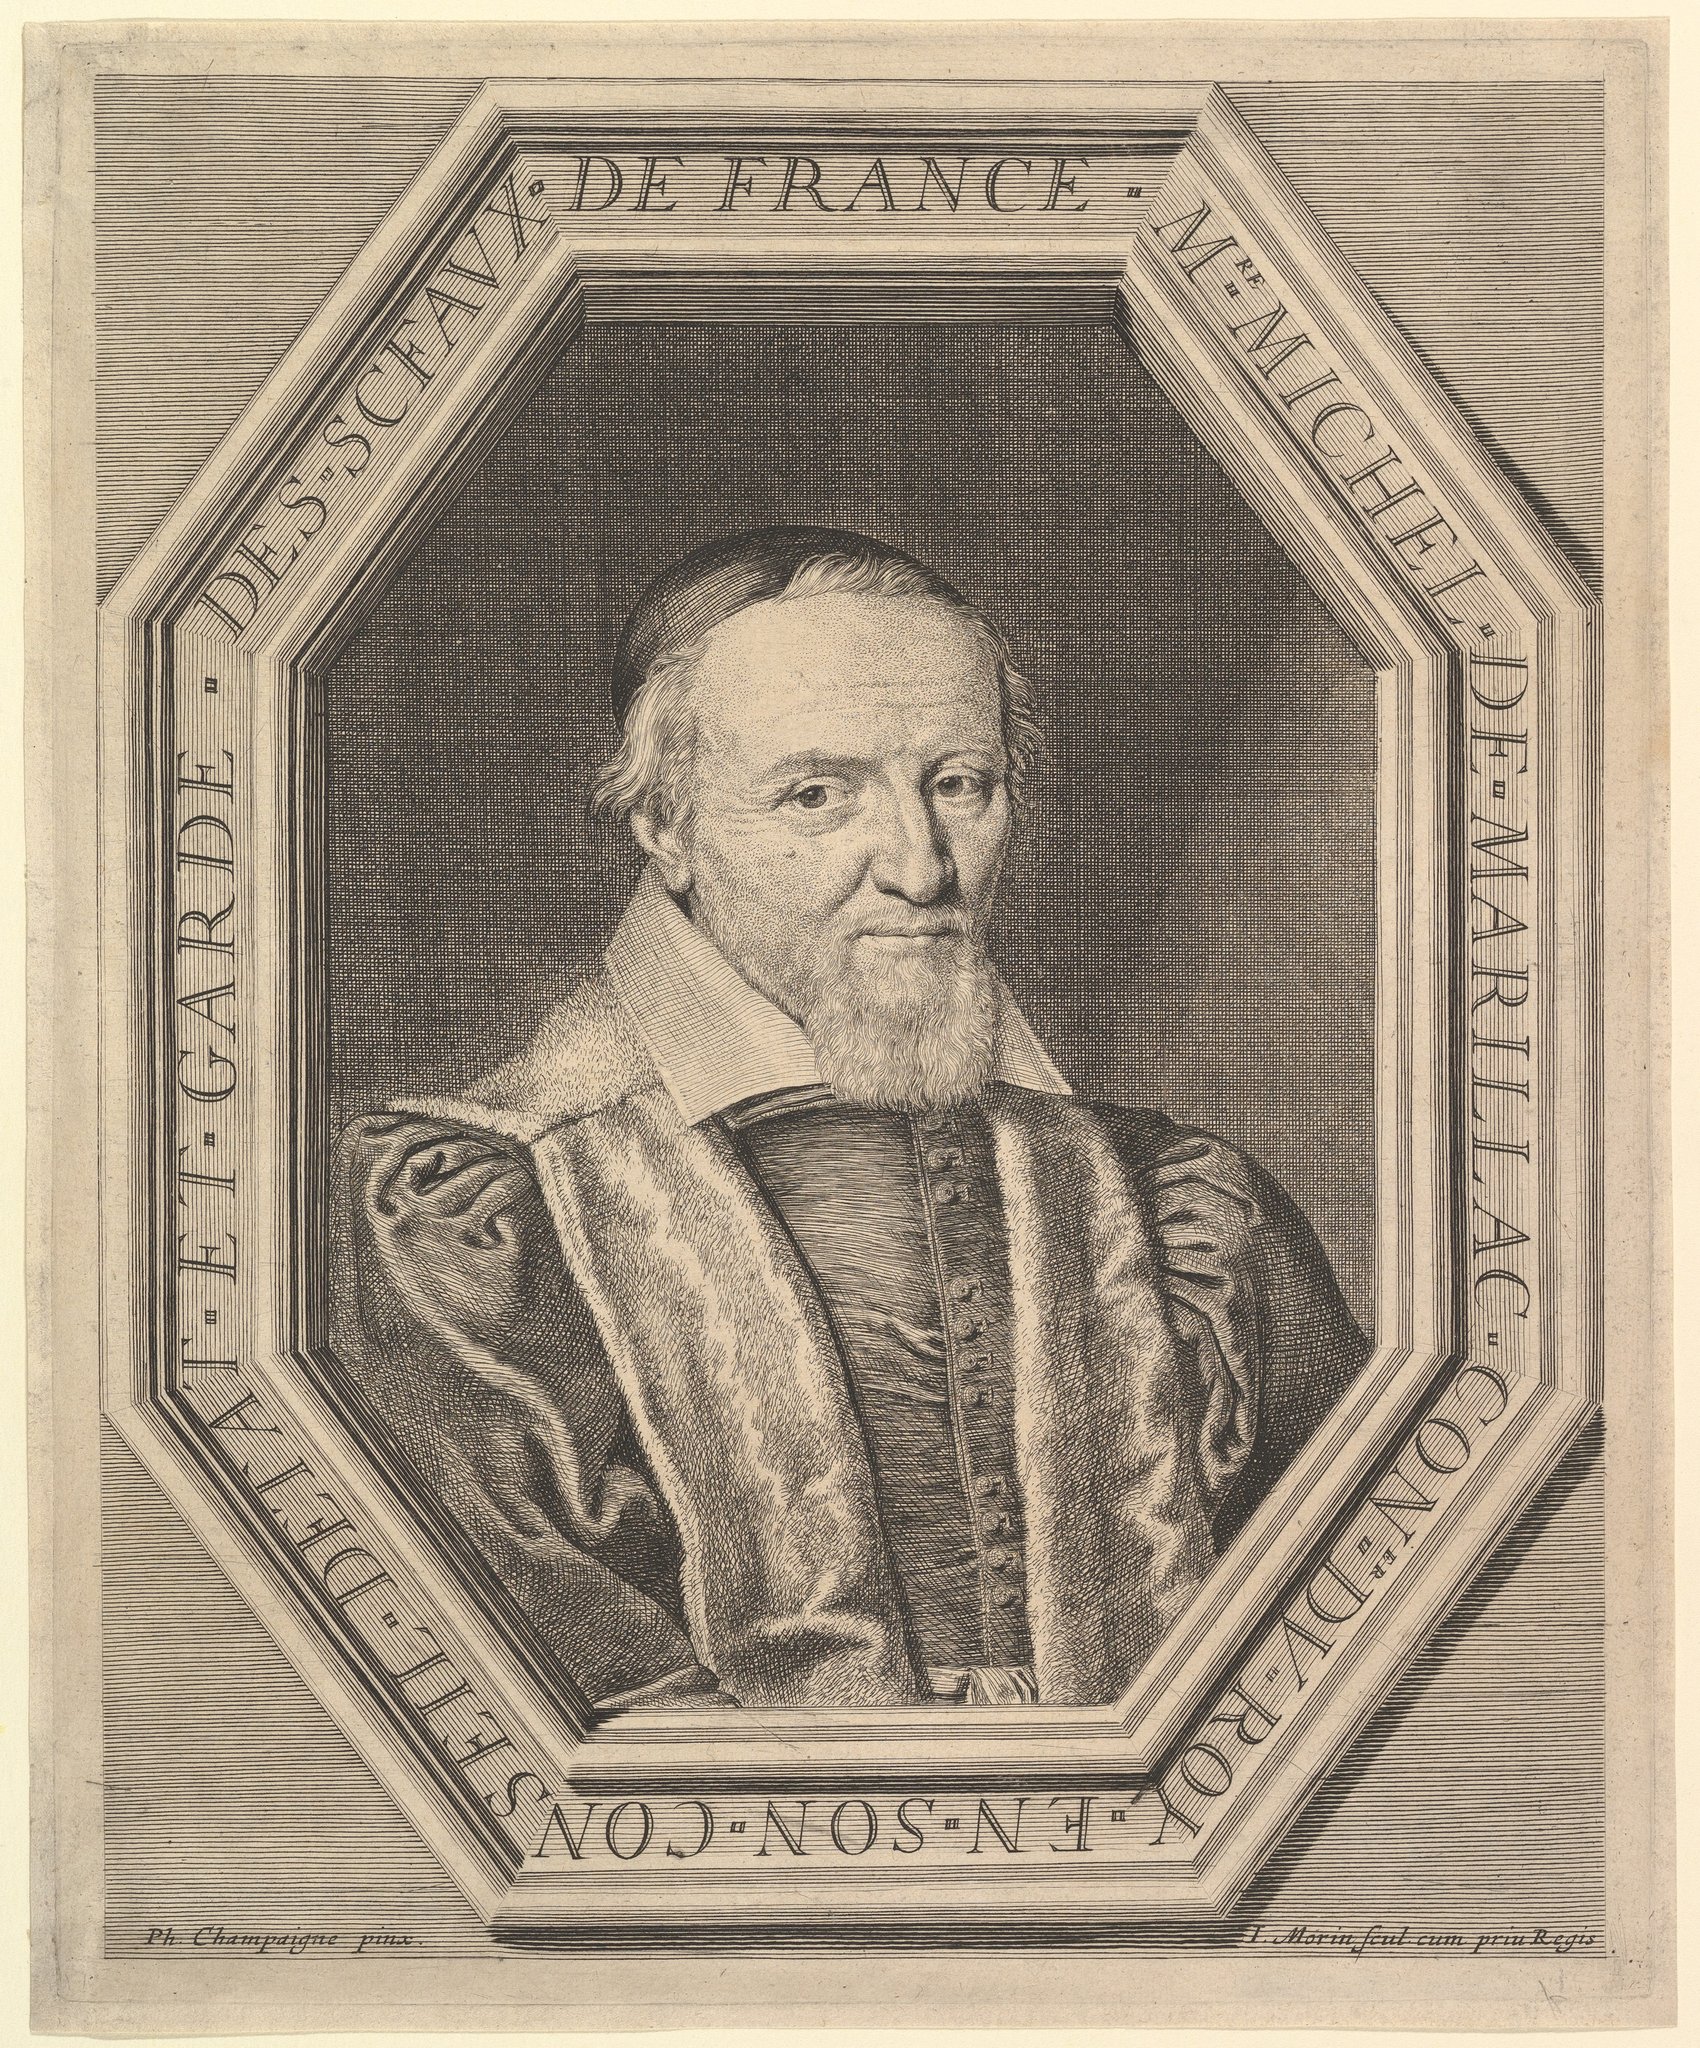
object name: print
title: Michel de Marillac, conseiller d'etat et garde des sceaux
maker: jean morin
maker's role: artist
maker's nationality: french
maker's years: 1605-1650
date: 1601-1700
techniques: etching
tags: men,portraits